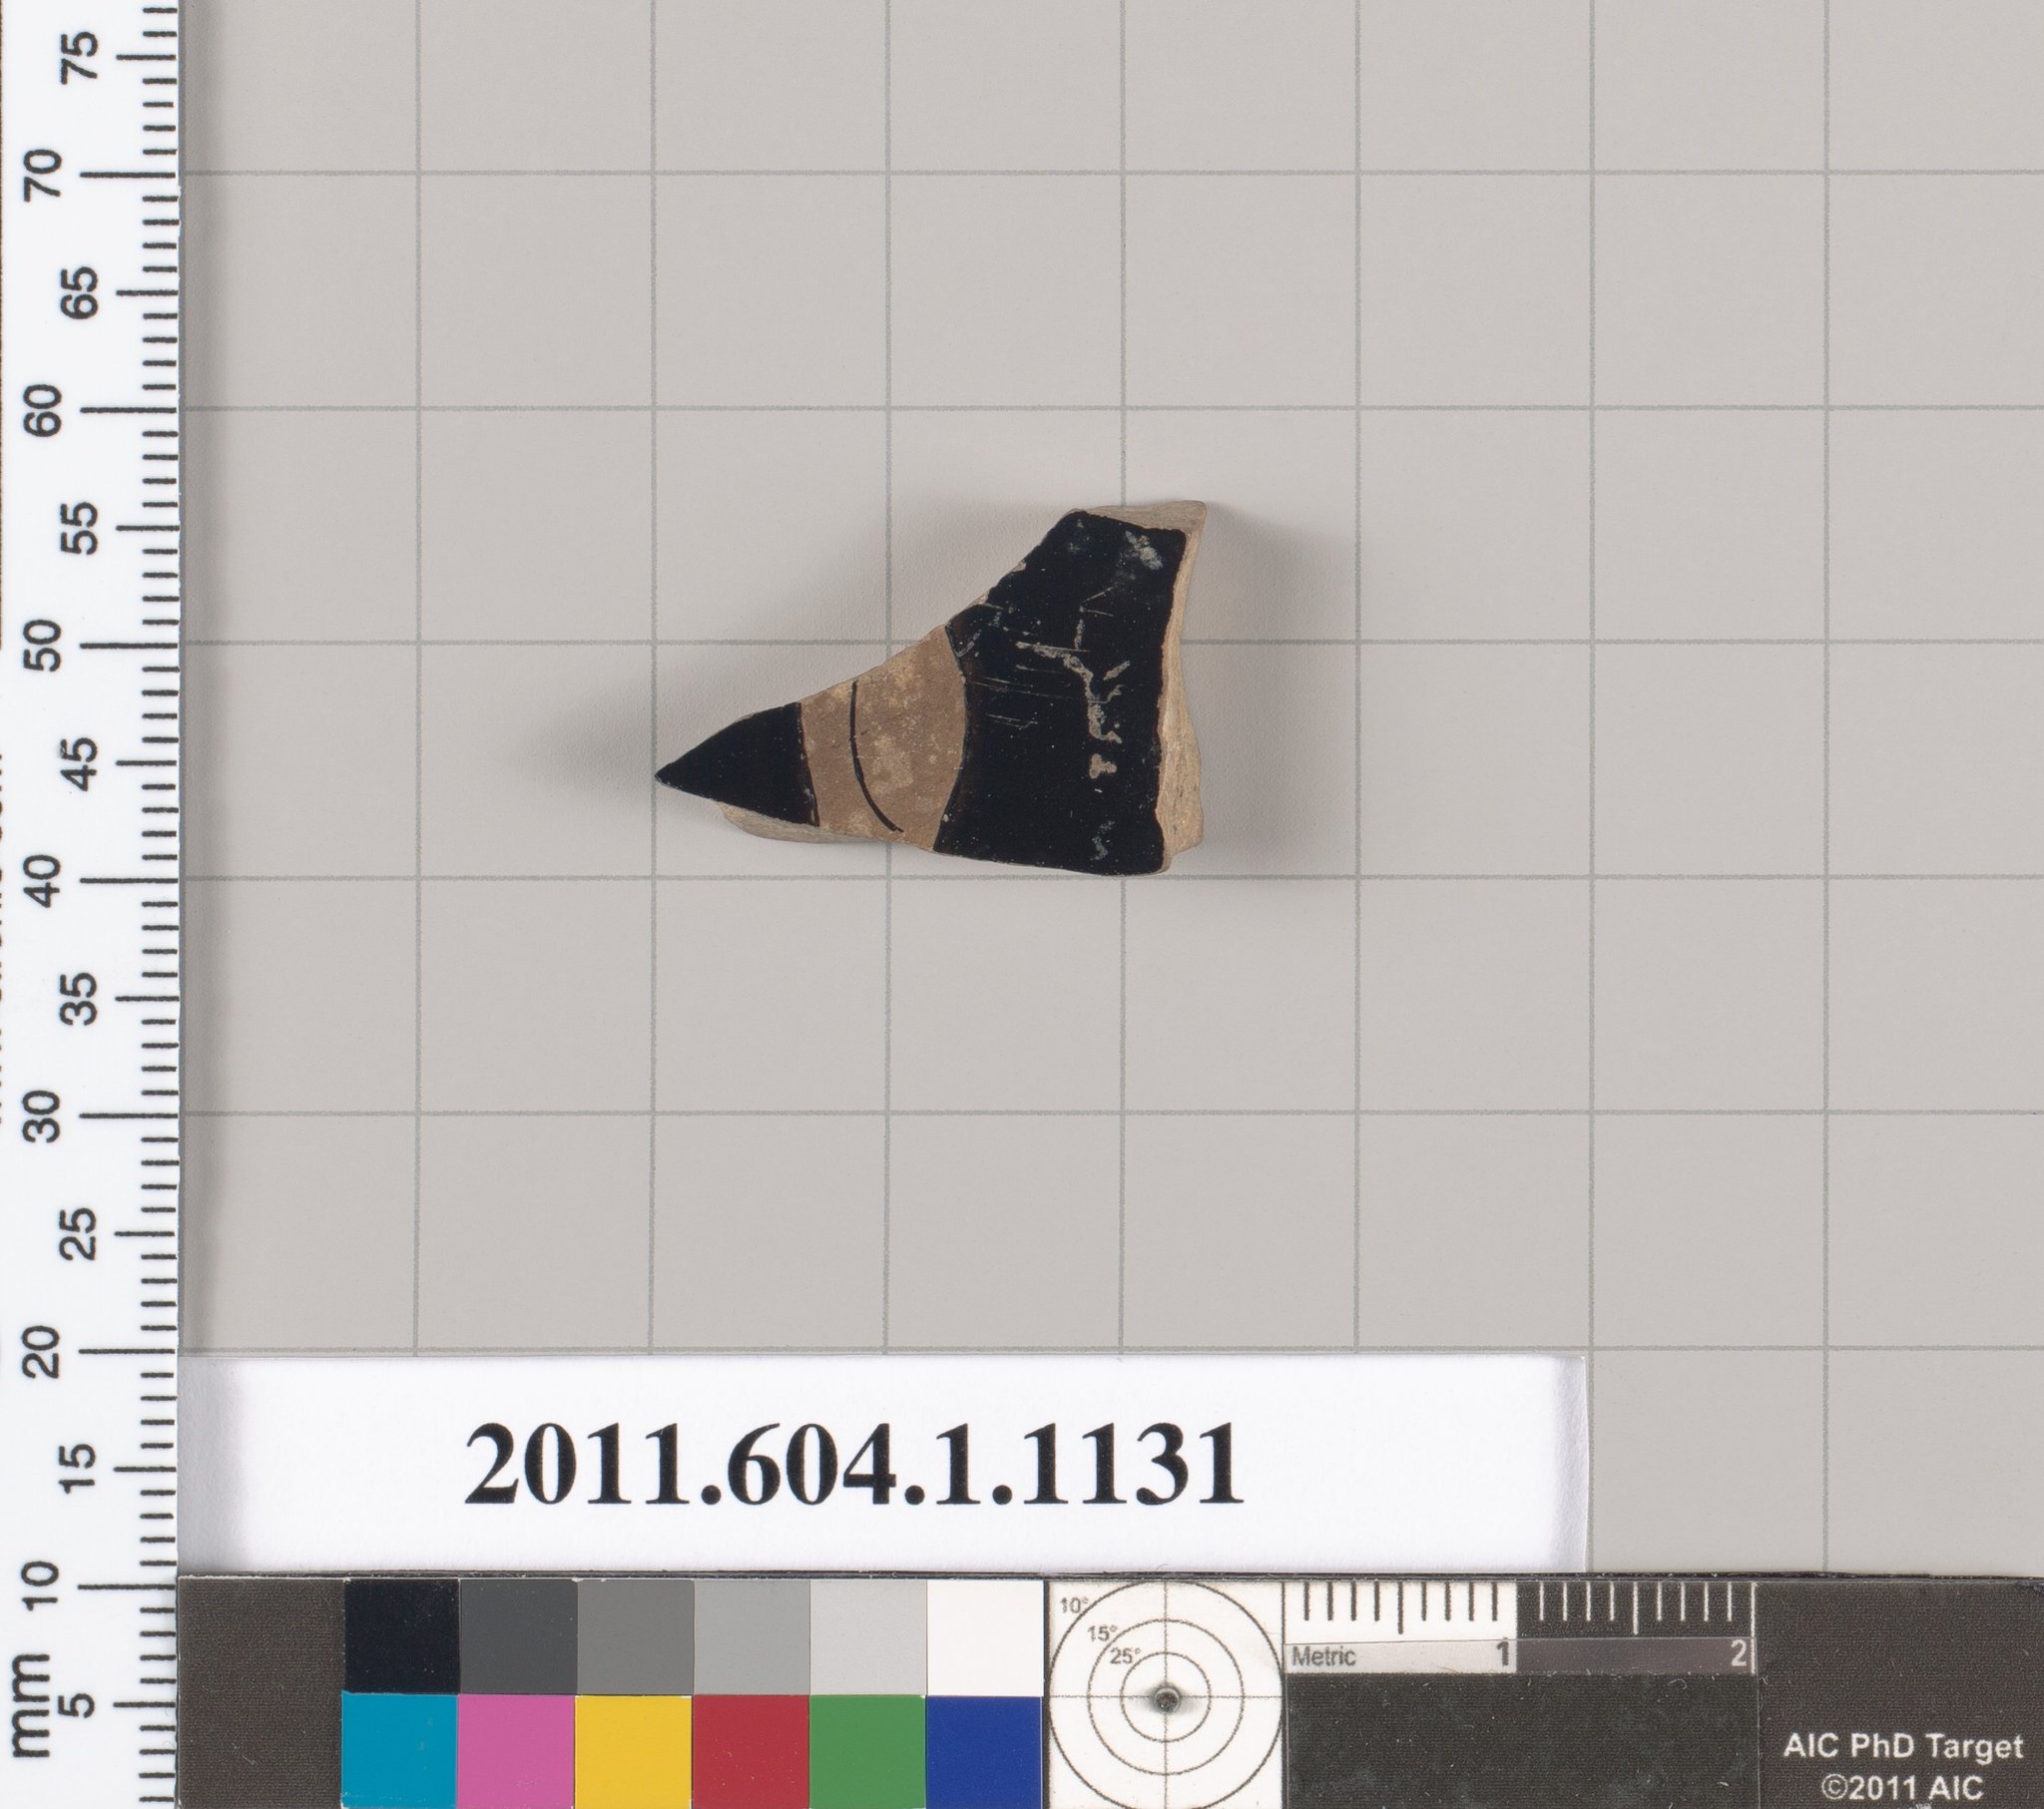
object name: kylix fragment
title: Terracotta fragment of a kylix (drinking cup)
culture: greek, attic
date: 475-451 BCE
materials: terracotta